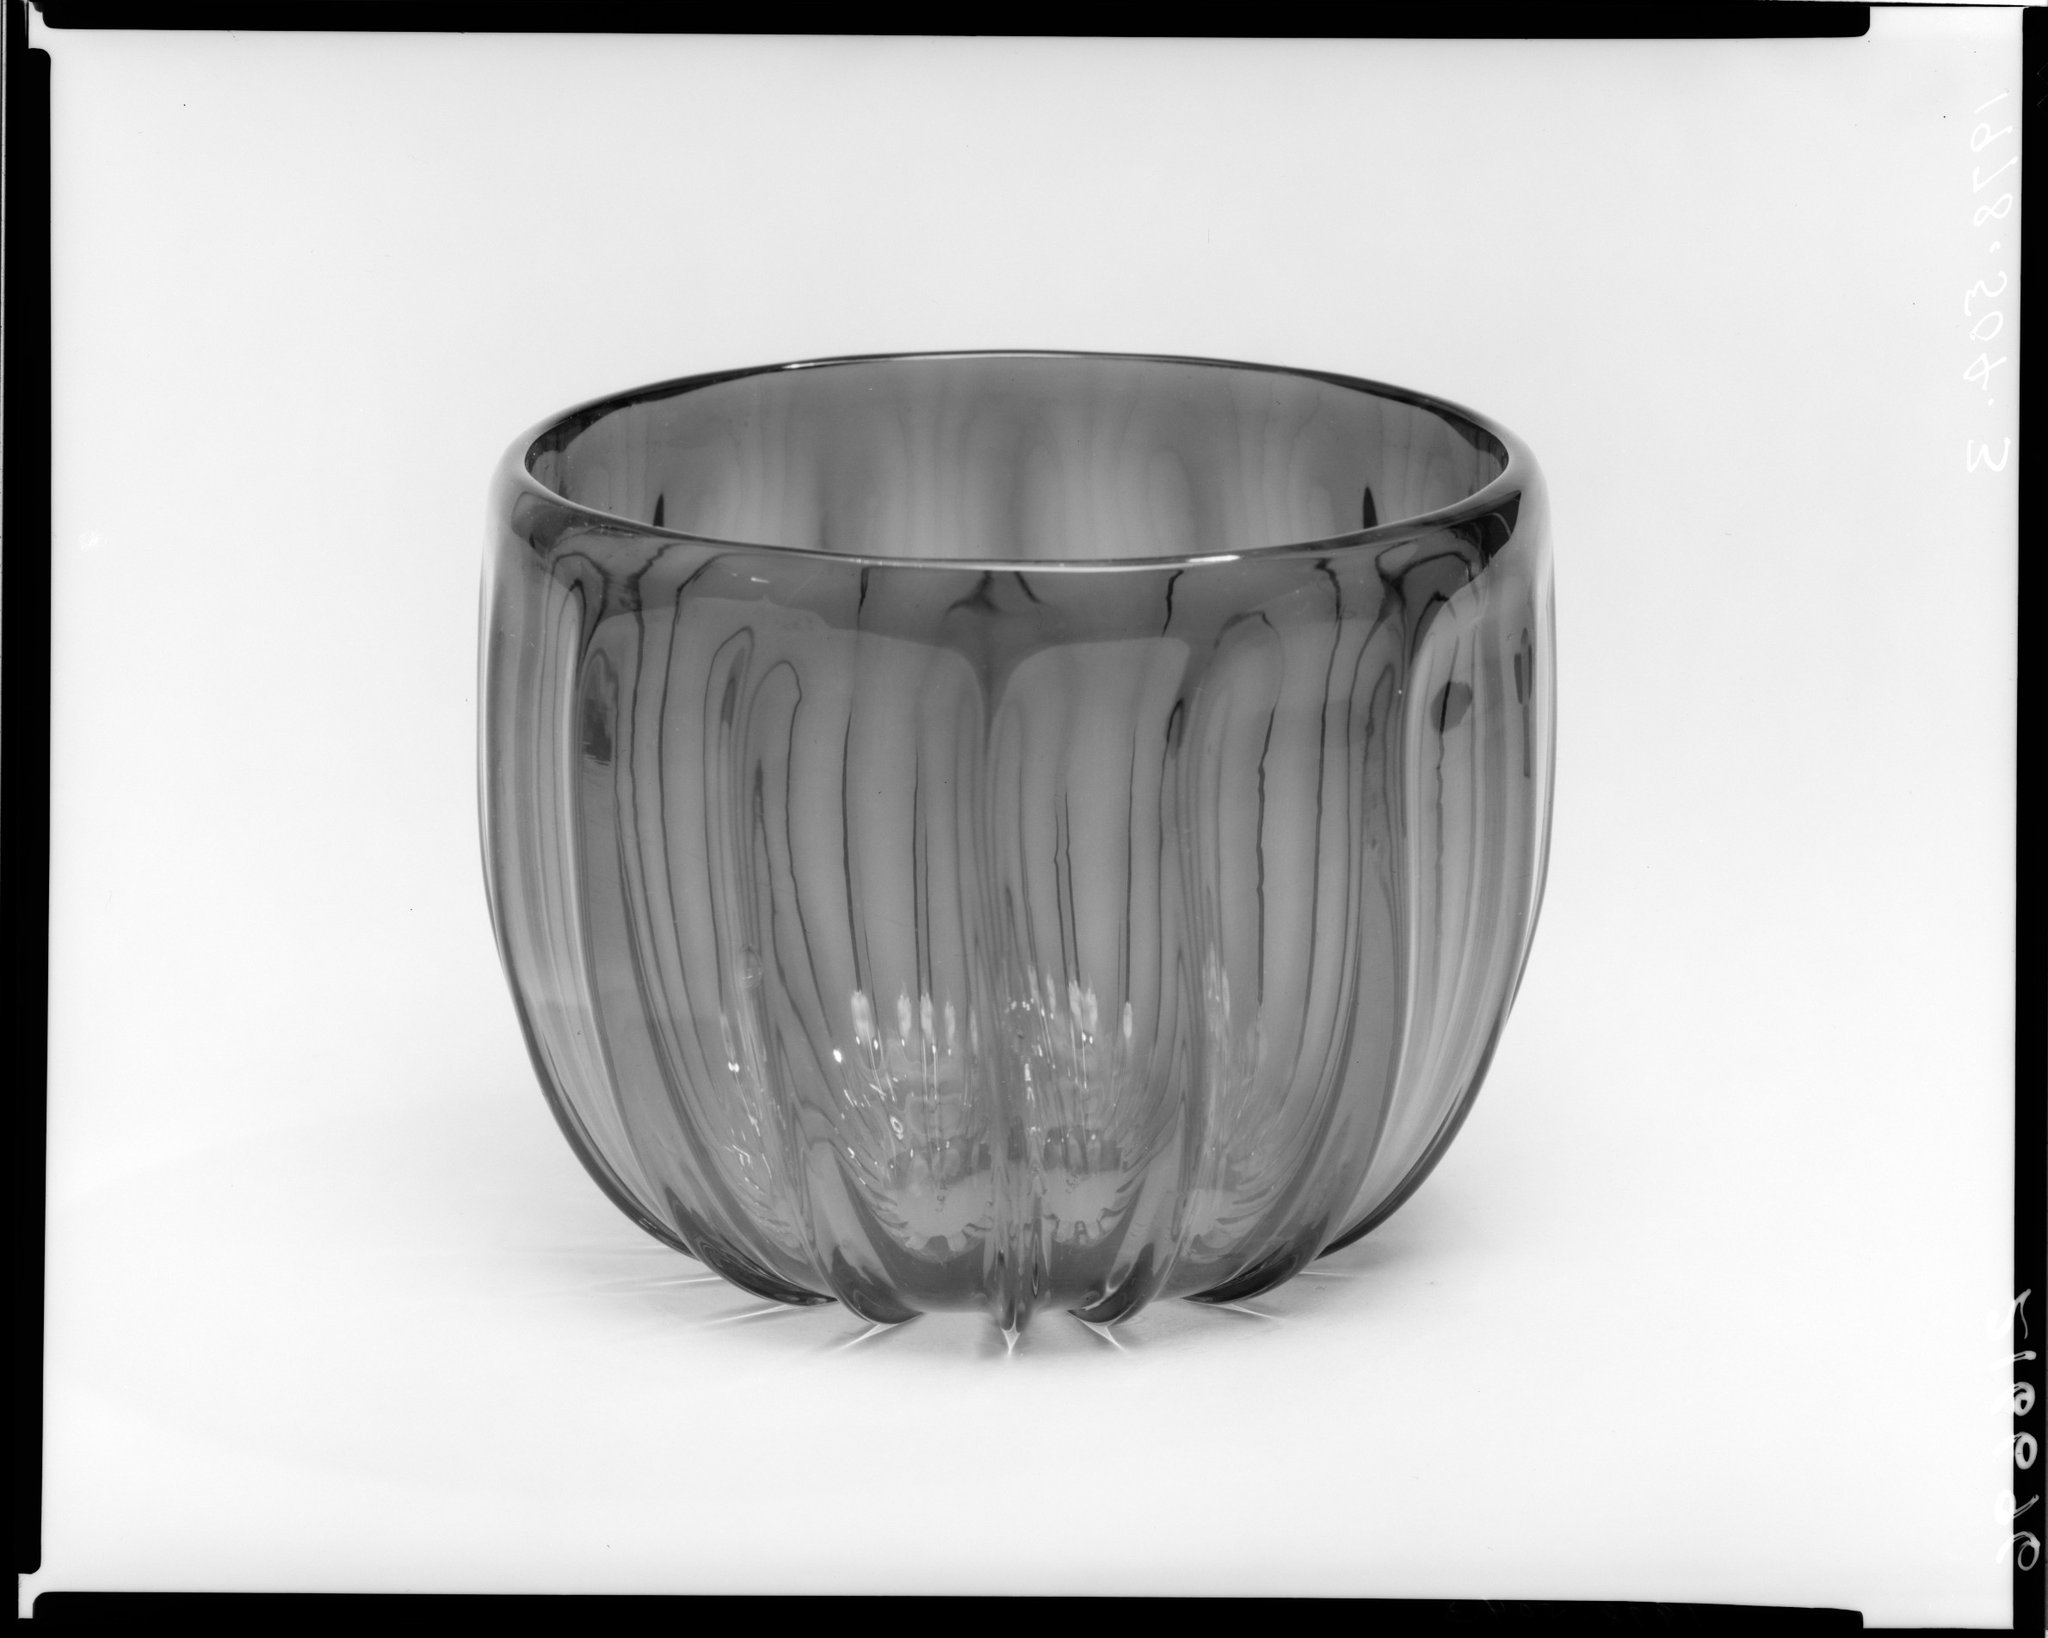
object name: finger bowl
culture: american or british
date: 1815-1850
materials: glass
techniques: glassblowing, molding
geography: england